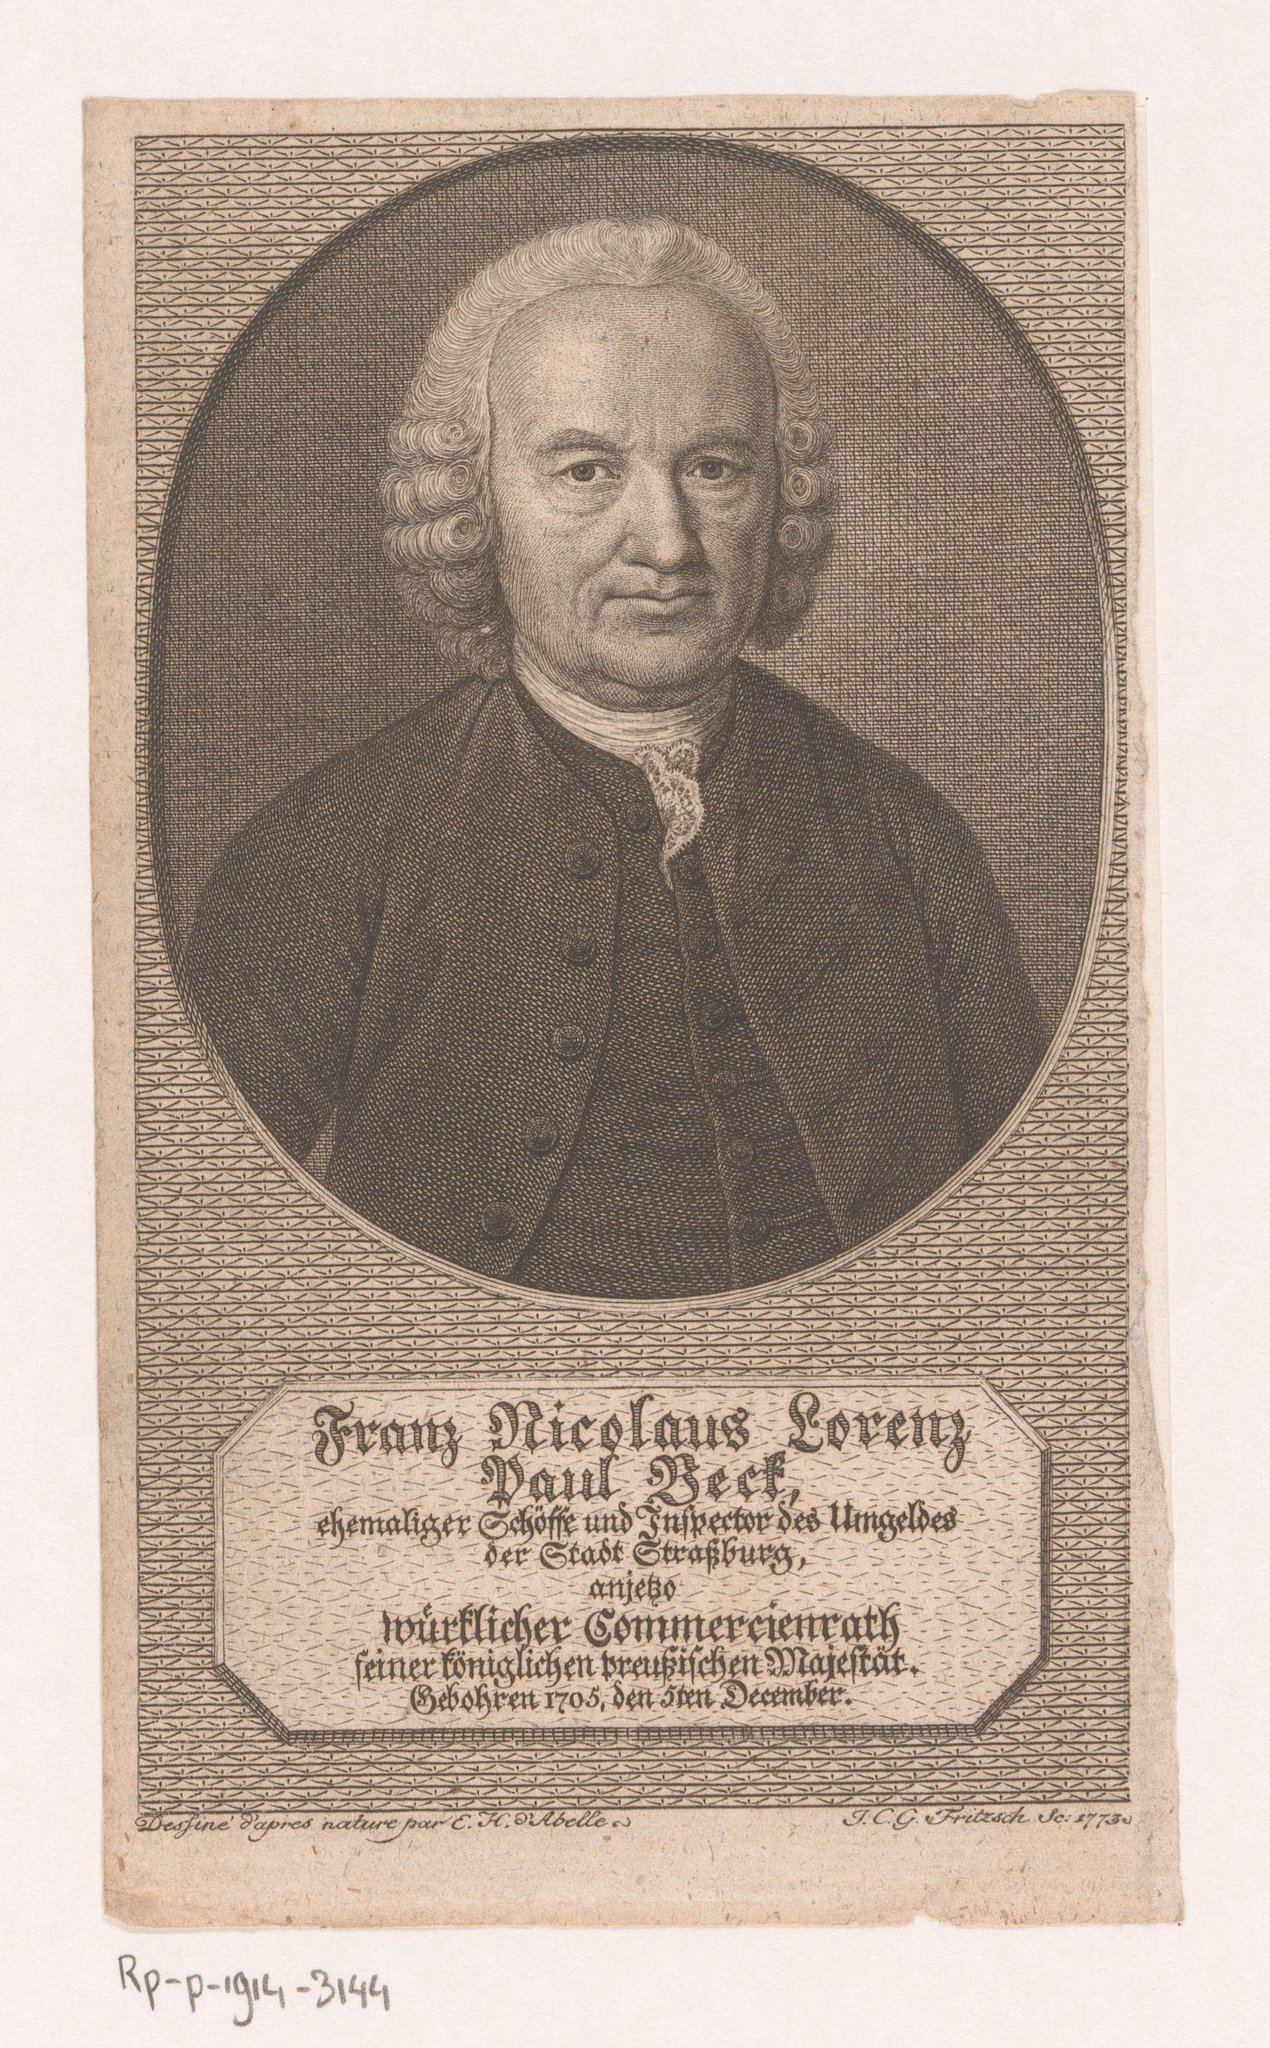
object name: print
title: Portret van Franz Nikolaus Lorenz Paul Beck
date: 1773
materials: paper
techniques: engraving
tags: historical persons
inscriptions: collector's mark: Lugt 2228